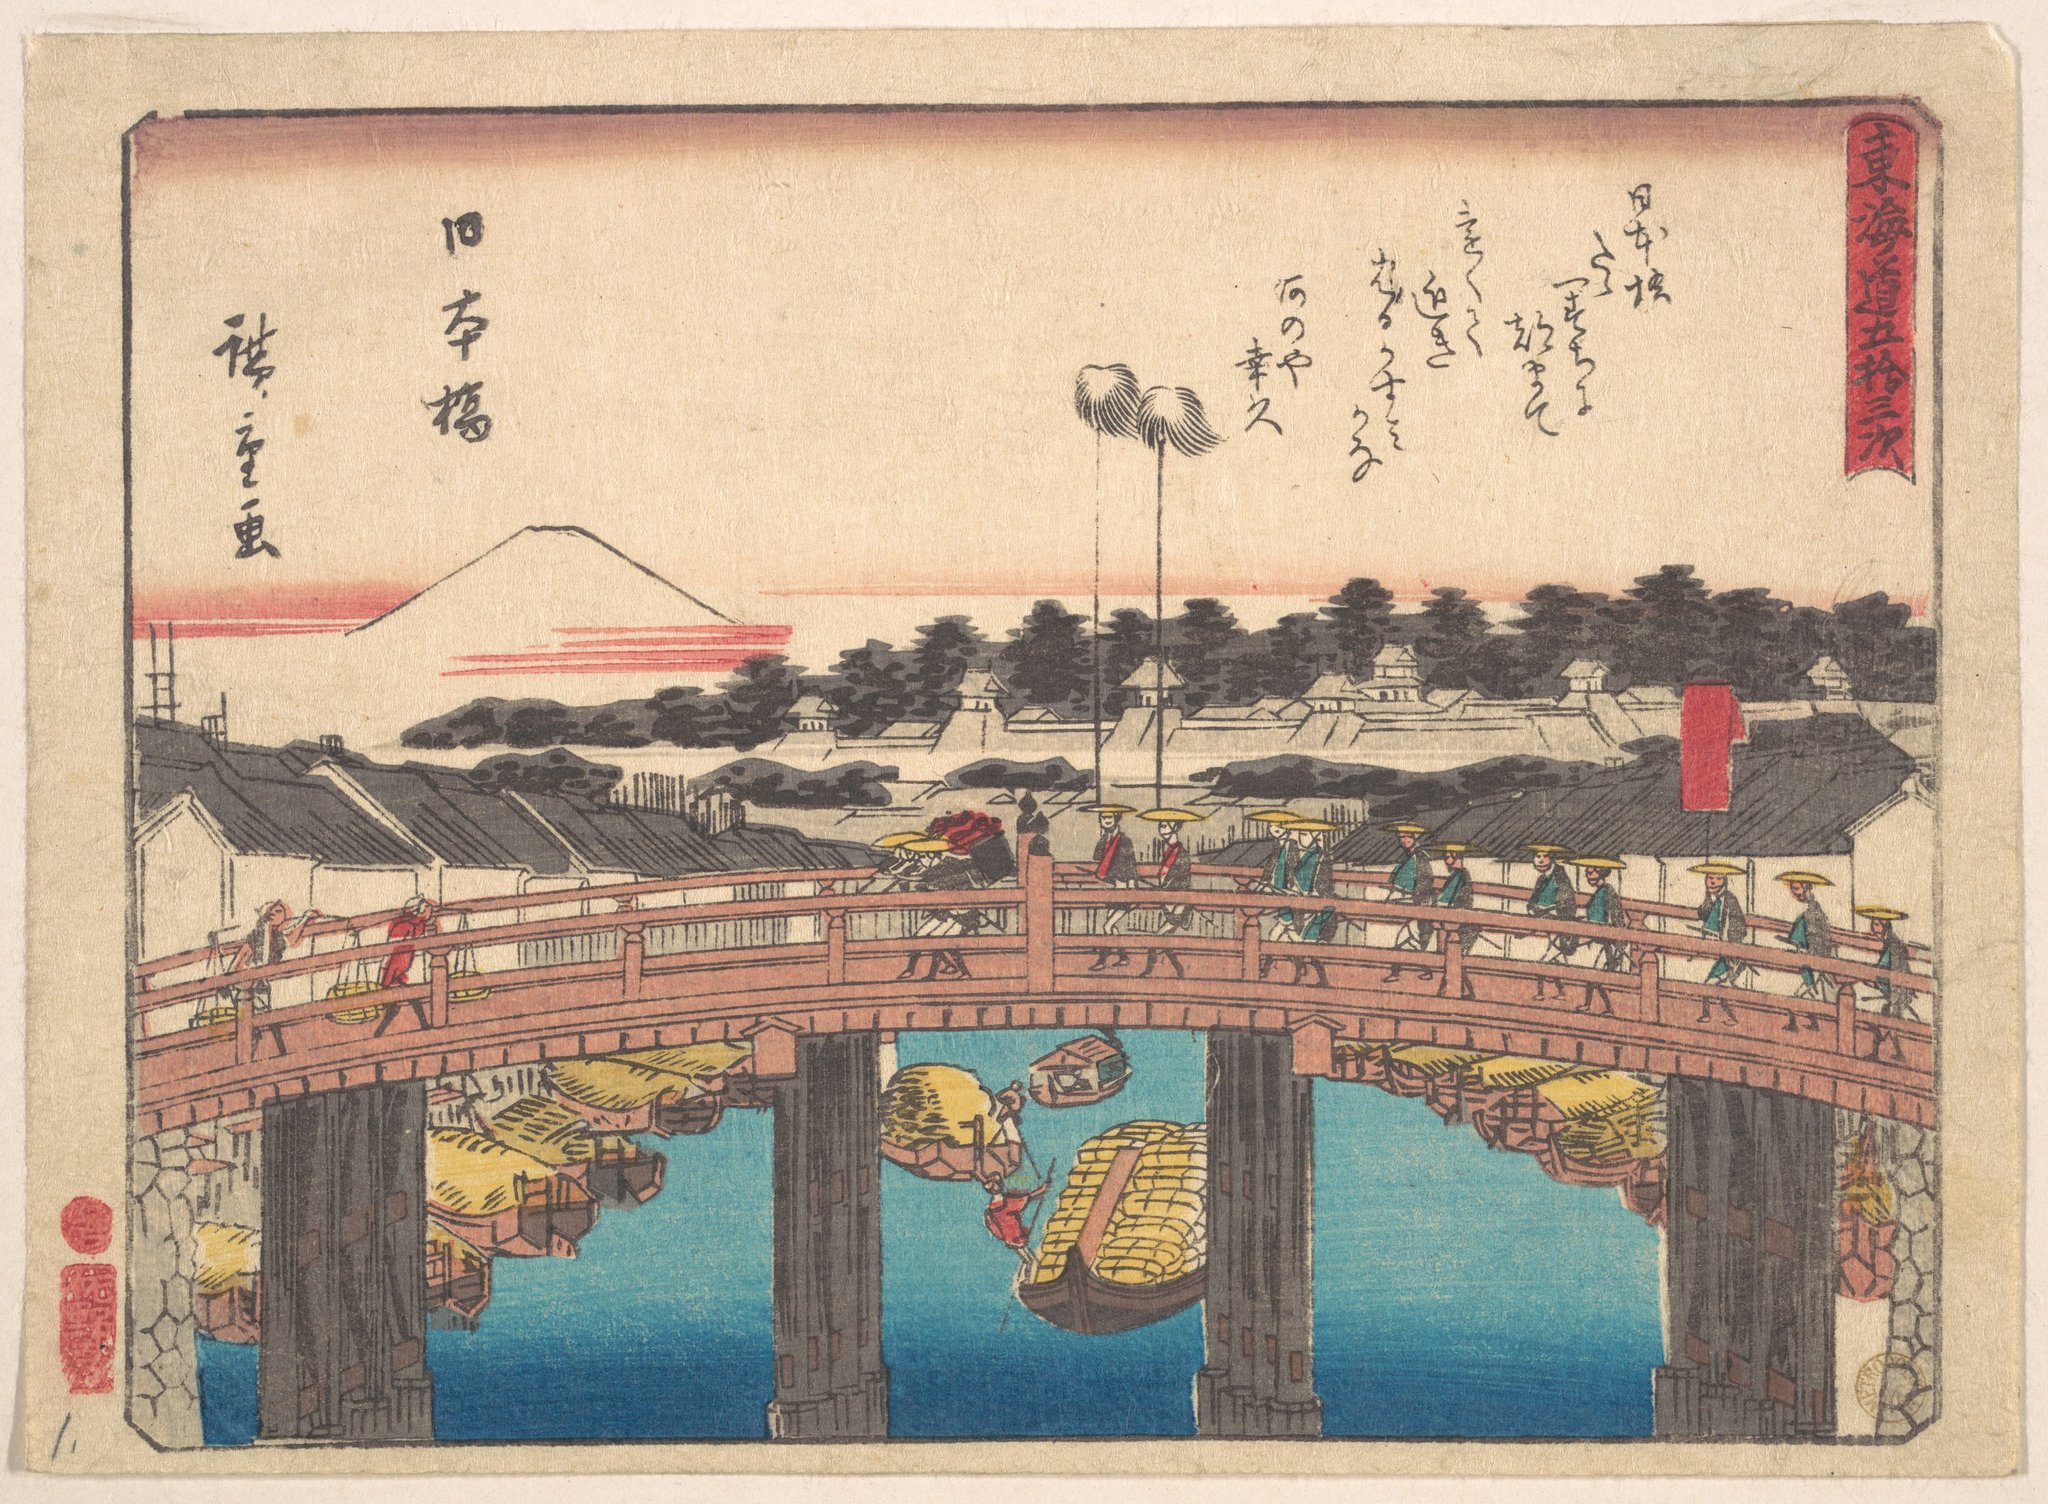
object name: print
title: Nihon Bashi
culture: japanese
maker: utagawa hiroshige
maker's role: artist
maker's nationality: japanese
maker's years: 1797-1858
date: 1838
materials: ink, paper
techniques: woodblock print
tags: human figures,bridges,boats